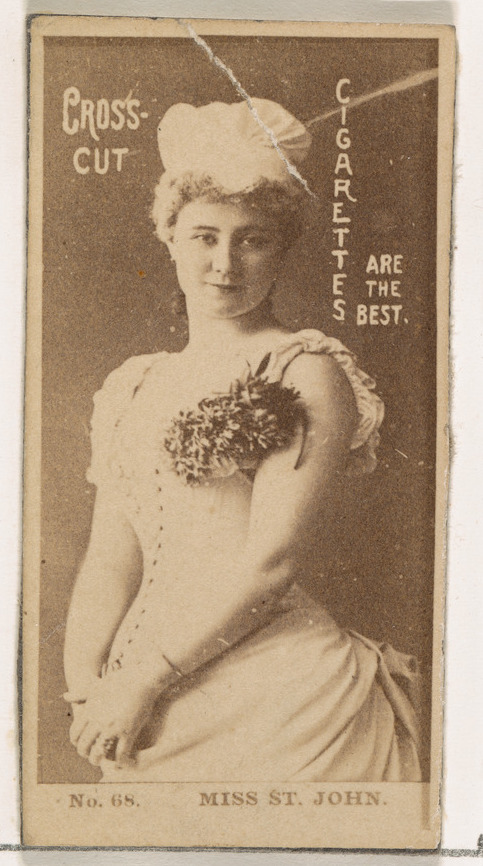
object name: print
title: Card Number 68, Miss St. John, from the Actors and Actresses series (N145-2) issued by Duke Sons & Co. to promote Cross Cut Cigarettes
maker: w. duke, sons & co.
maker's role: publisher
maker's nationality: american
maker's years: 1870-1920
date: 1880-1889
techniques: albumen silver print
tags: portraits,women,actresses